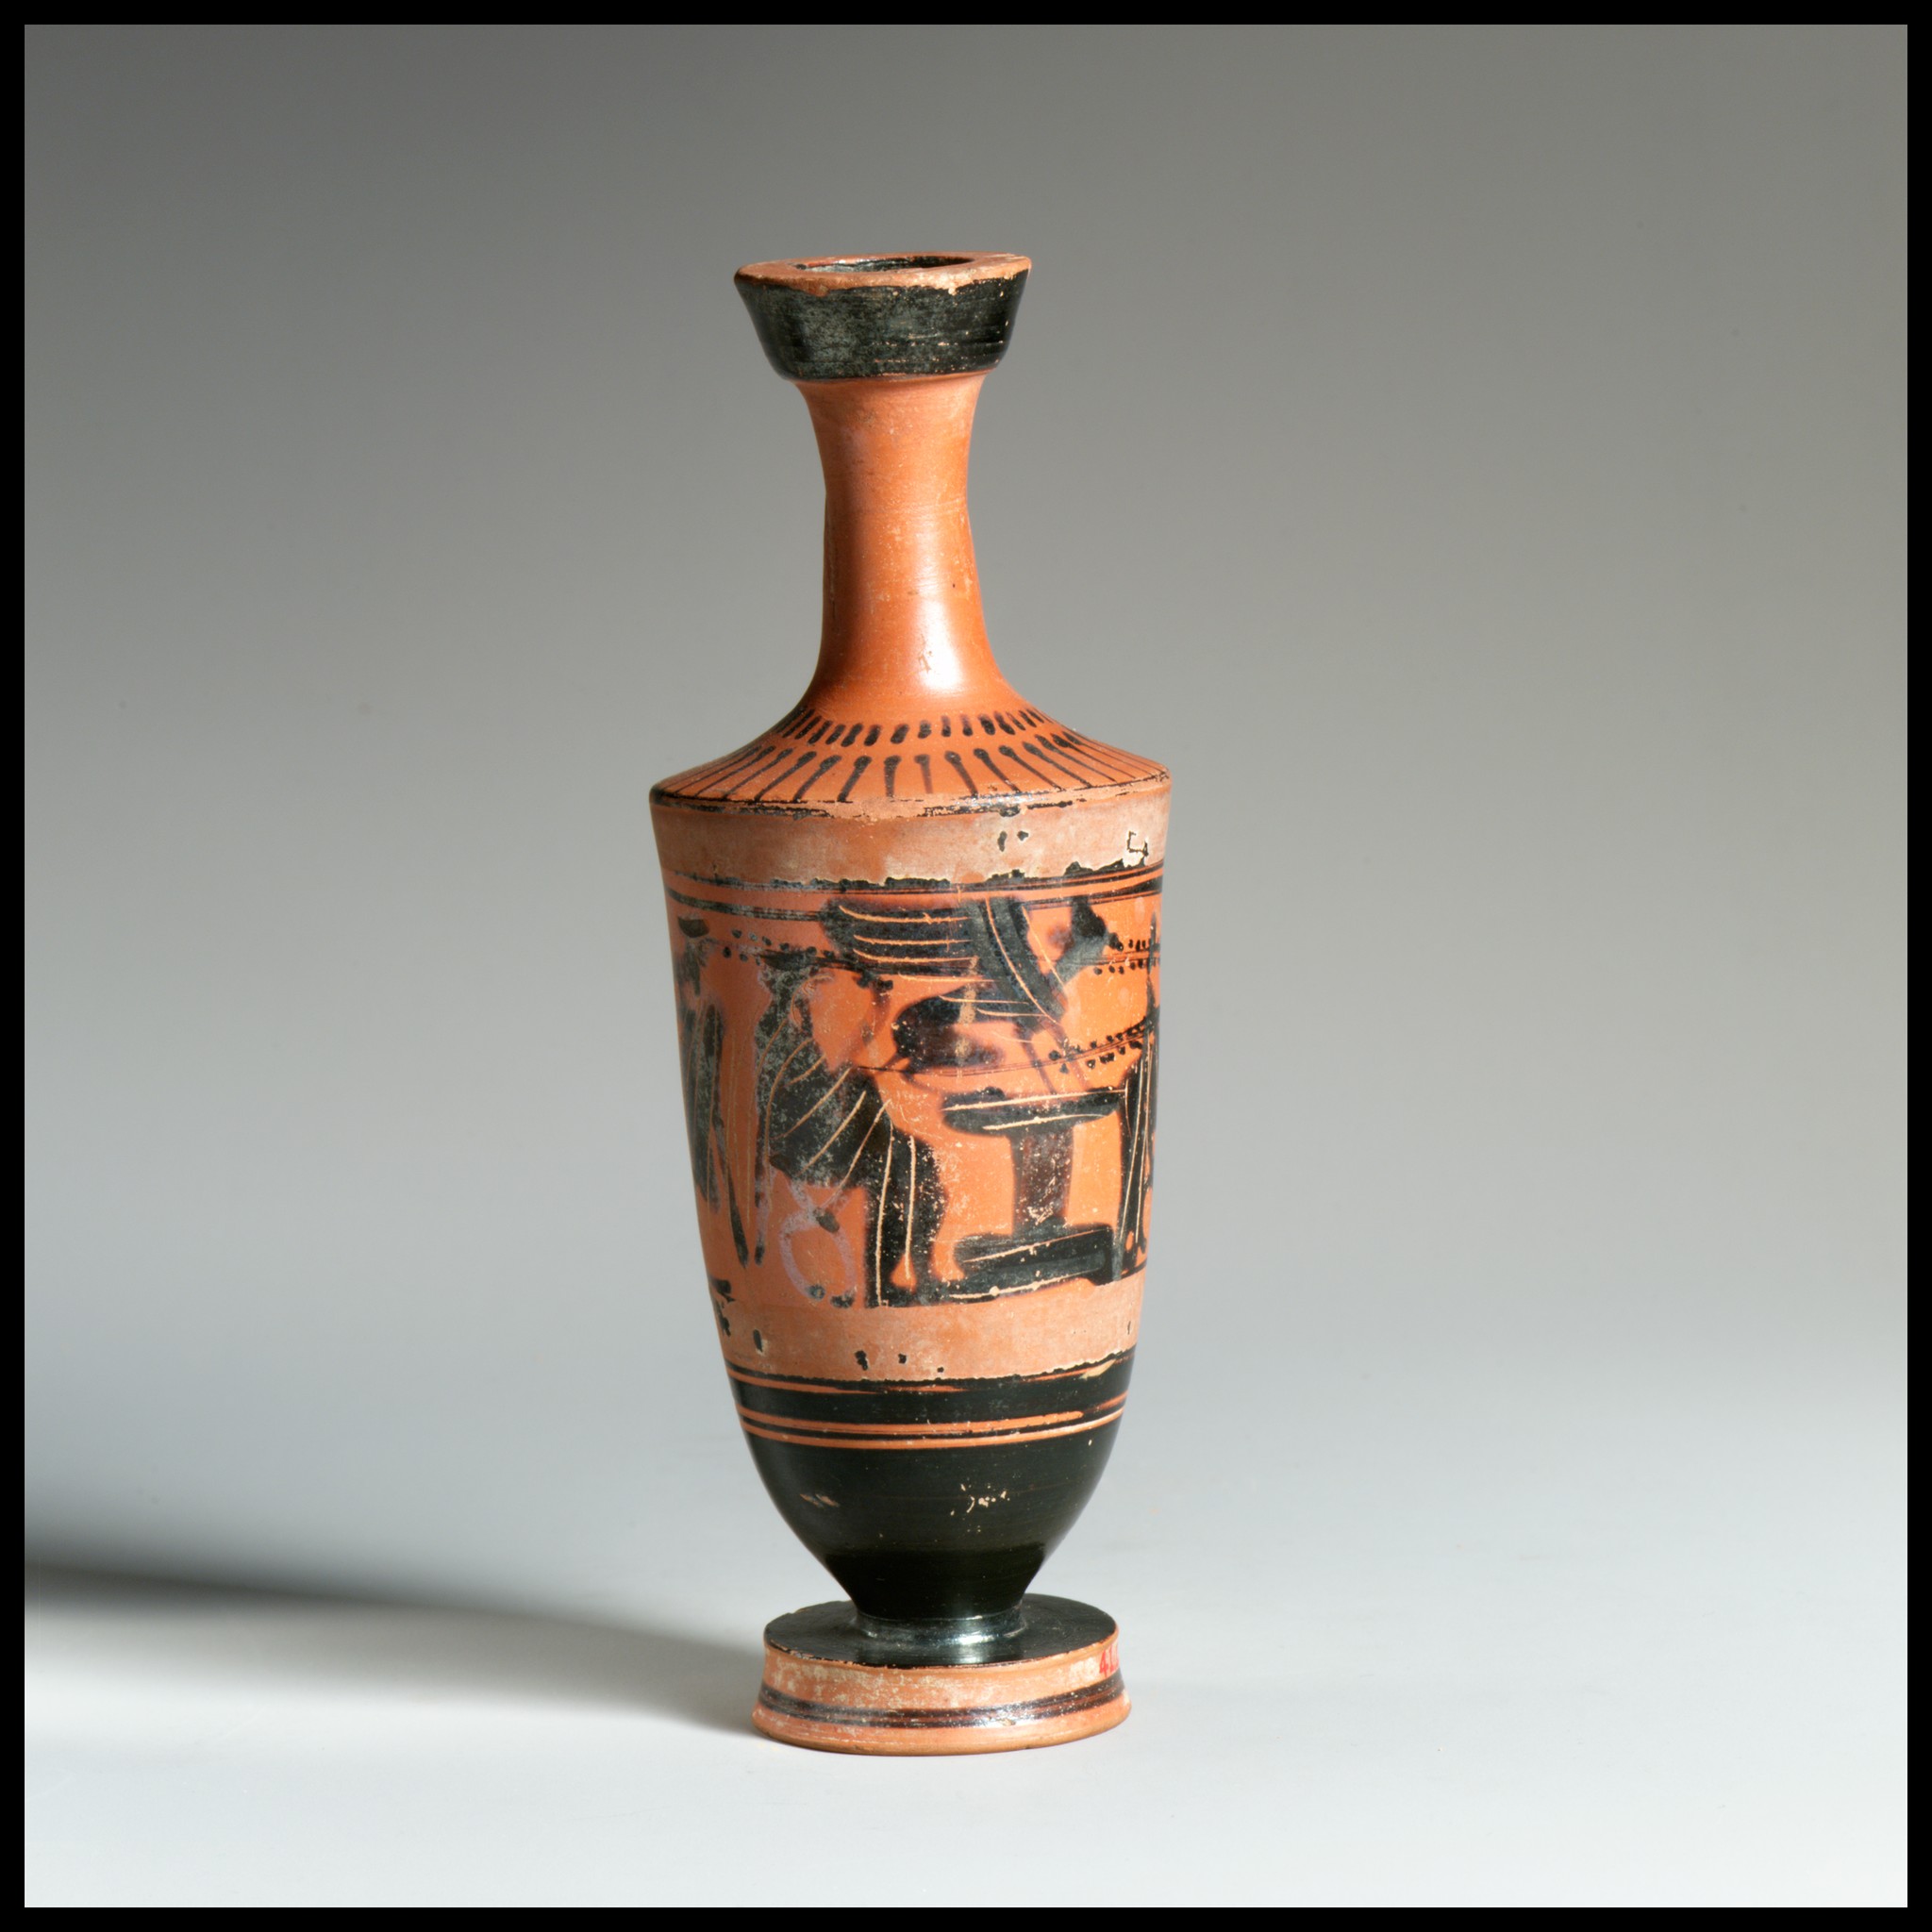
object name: lekythos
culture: greek, attic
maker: haimon painter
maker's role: artist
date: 500-476 BCE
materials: terracotta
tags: men,sphinx